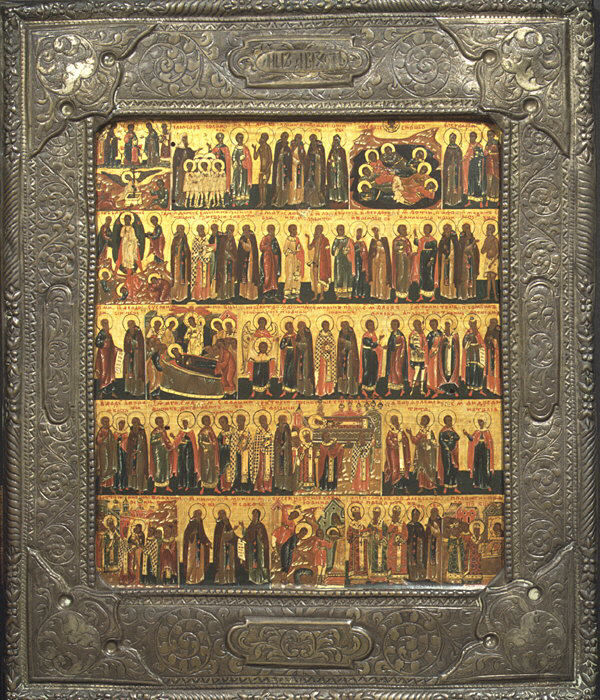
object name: painting, icon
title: Calendar of Saints and Festivals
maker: russian painter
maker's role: artist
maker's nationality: russian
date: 1600-1799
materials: gold leaf, paint, wood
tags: saints,calendars